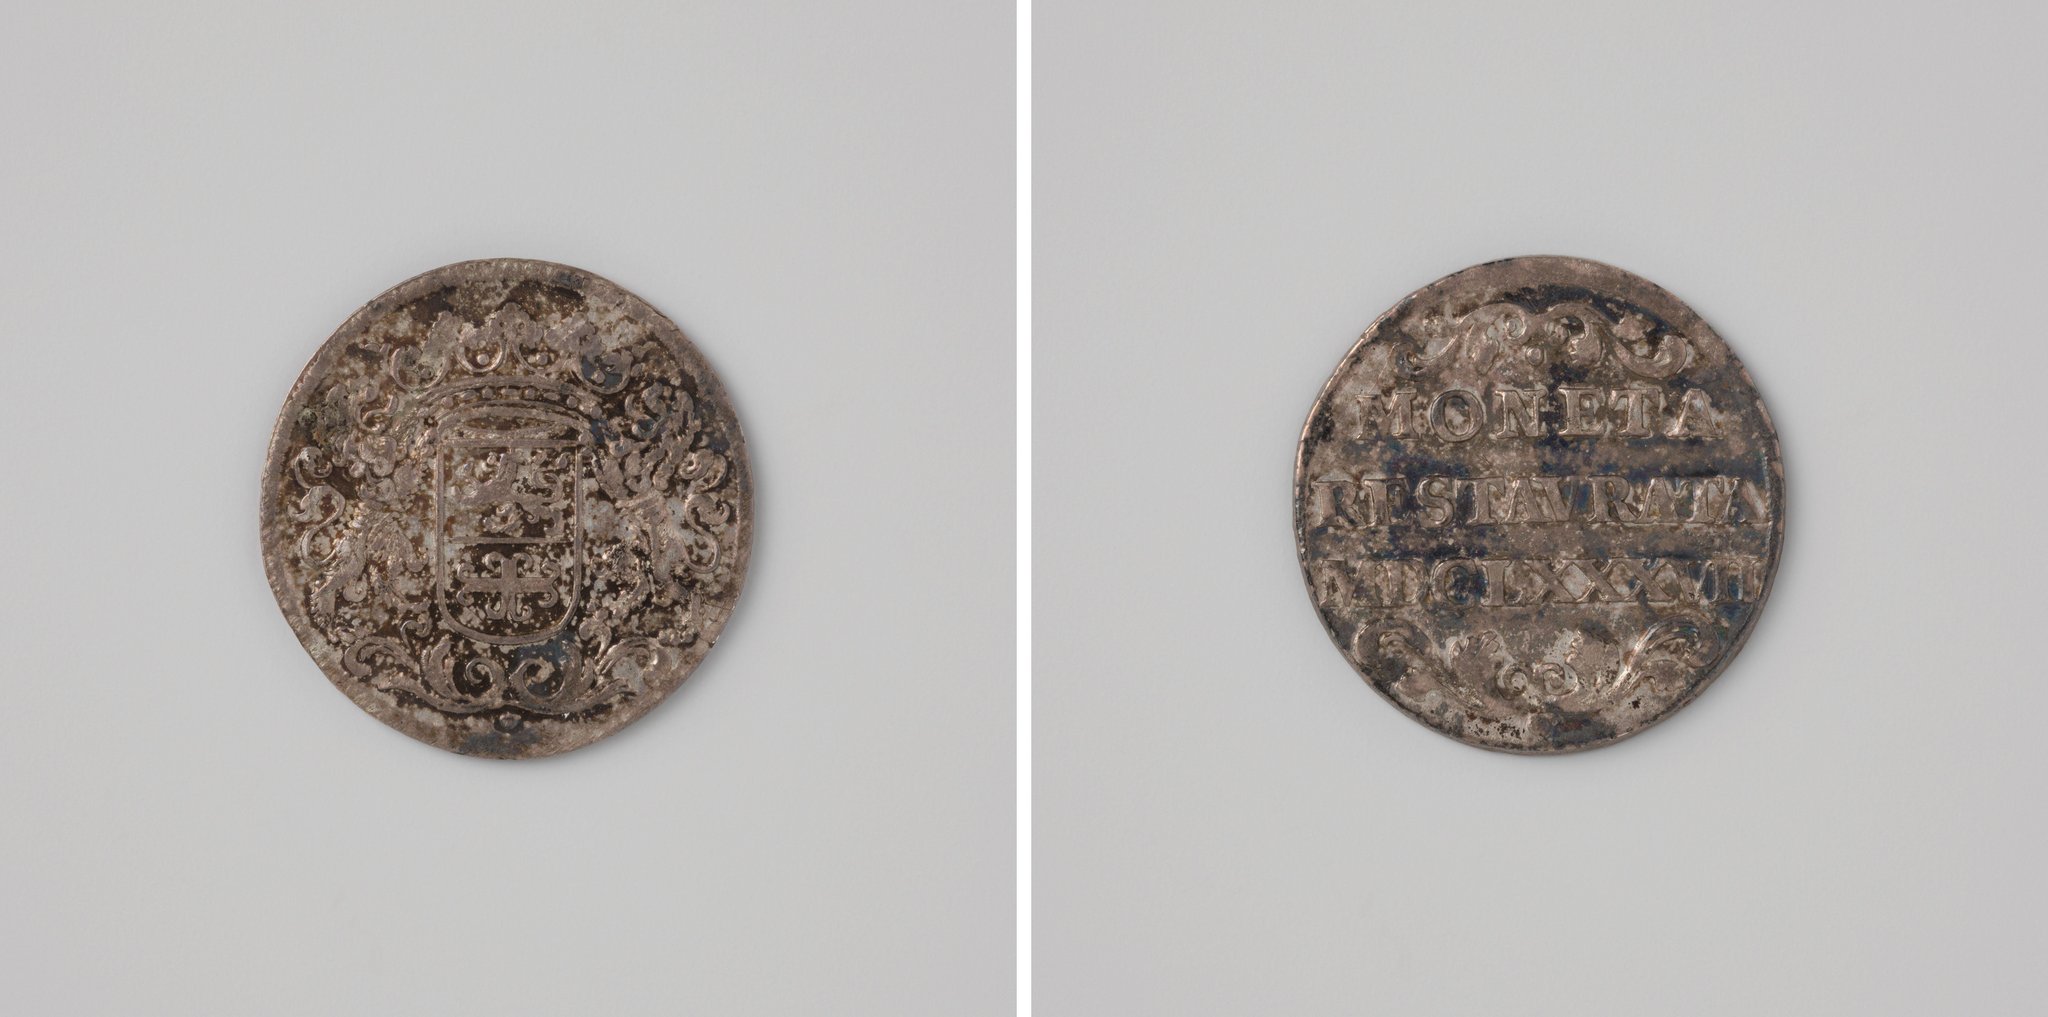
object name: history medal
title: Munt te Zutphen hersteld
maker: herman van bayen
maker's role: mintmaster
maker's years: 1688-1698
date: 1687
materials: silver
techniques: striking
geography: zutphen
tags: zutphen (stad)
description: Zilveren penning. Voorzijde: gekroond wapenschild door twee leeuwen geflankeerd. Keerzijde: opschrift.